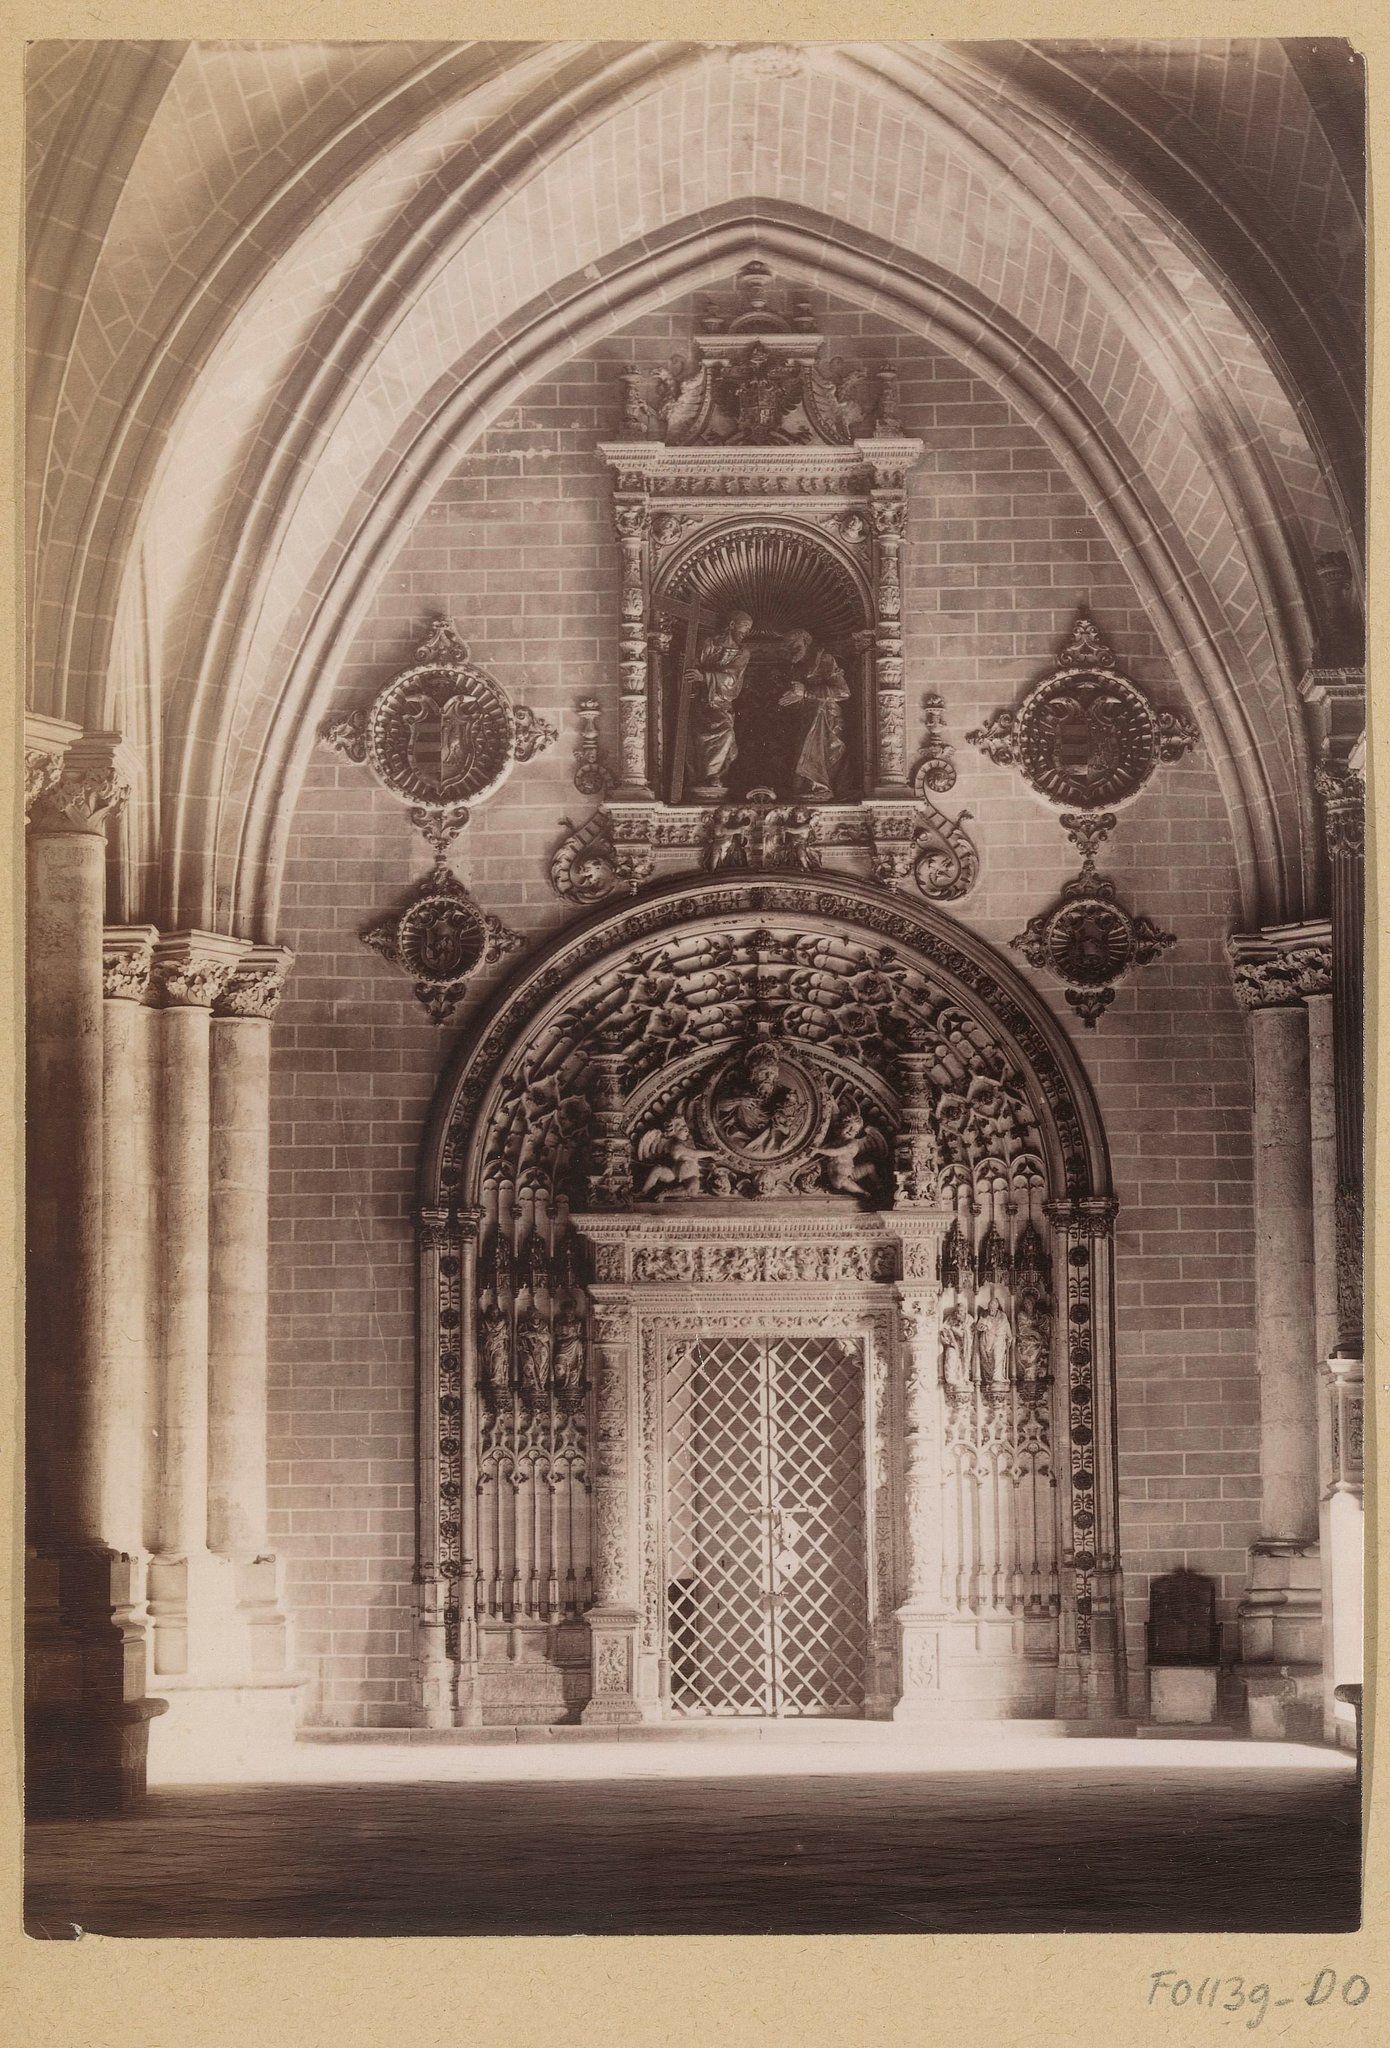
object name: photograph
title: Portaal van een kerk, mogelijk in Toledo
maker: Anonymous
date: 1851-1890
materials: paper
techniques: albumen print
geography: toledo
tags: parts of church exterior and annexes: portal